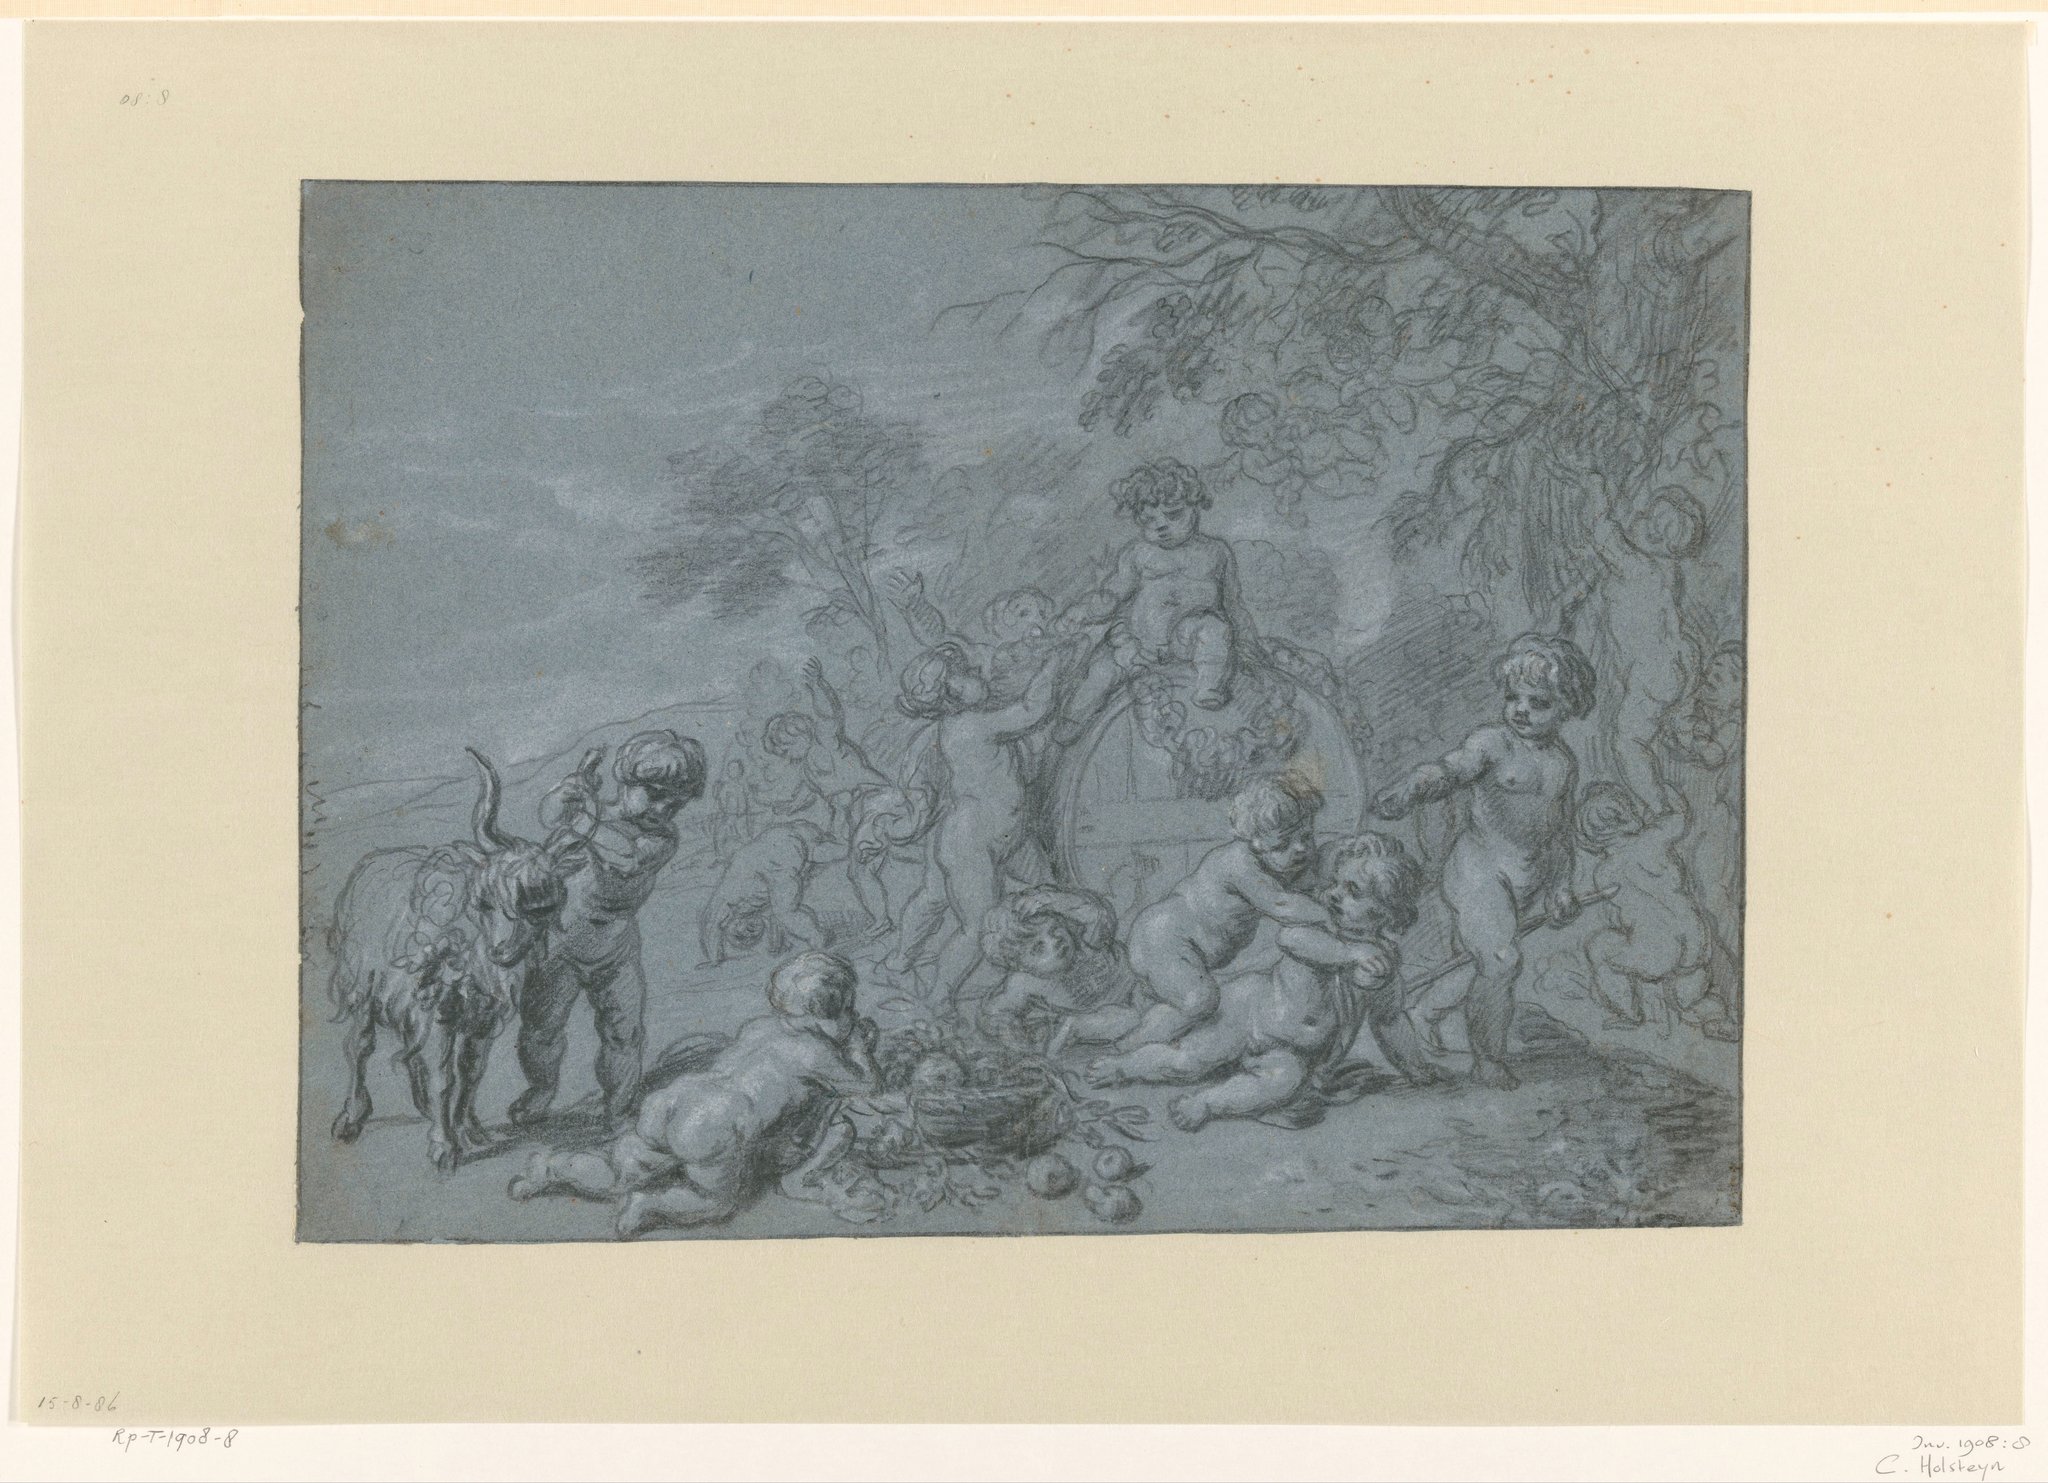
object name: drawing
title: Bacchus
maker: cornelis holsteyn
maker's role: draughtsman, painter, print maker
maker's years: 1618-1658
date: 1628-1658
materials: chalk, paper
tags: children's bacchanal